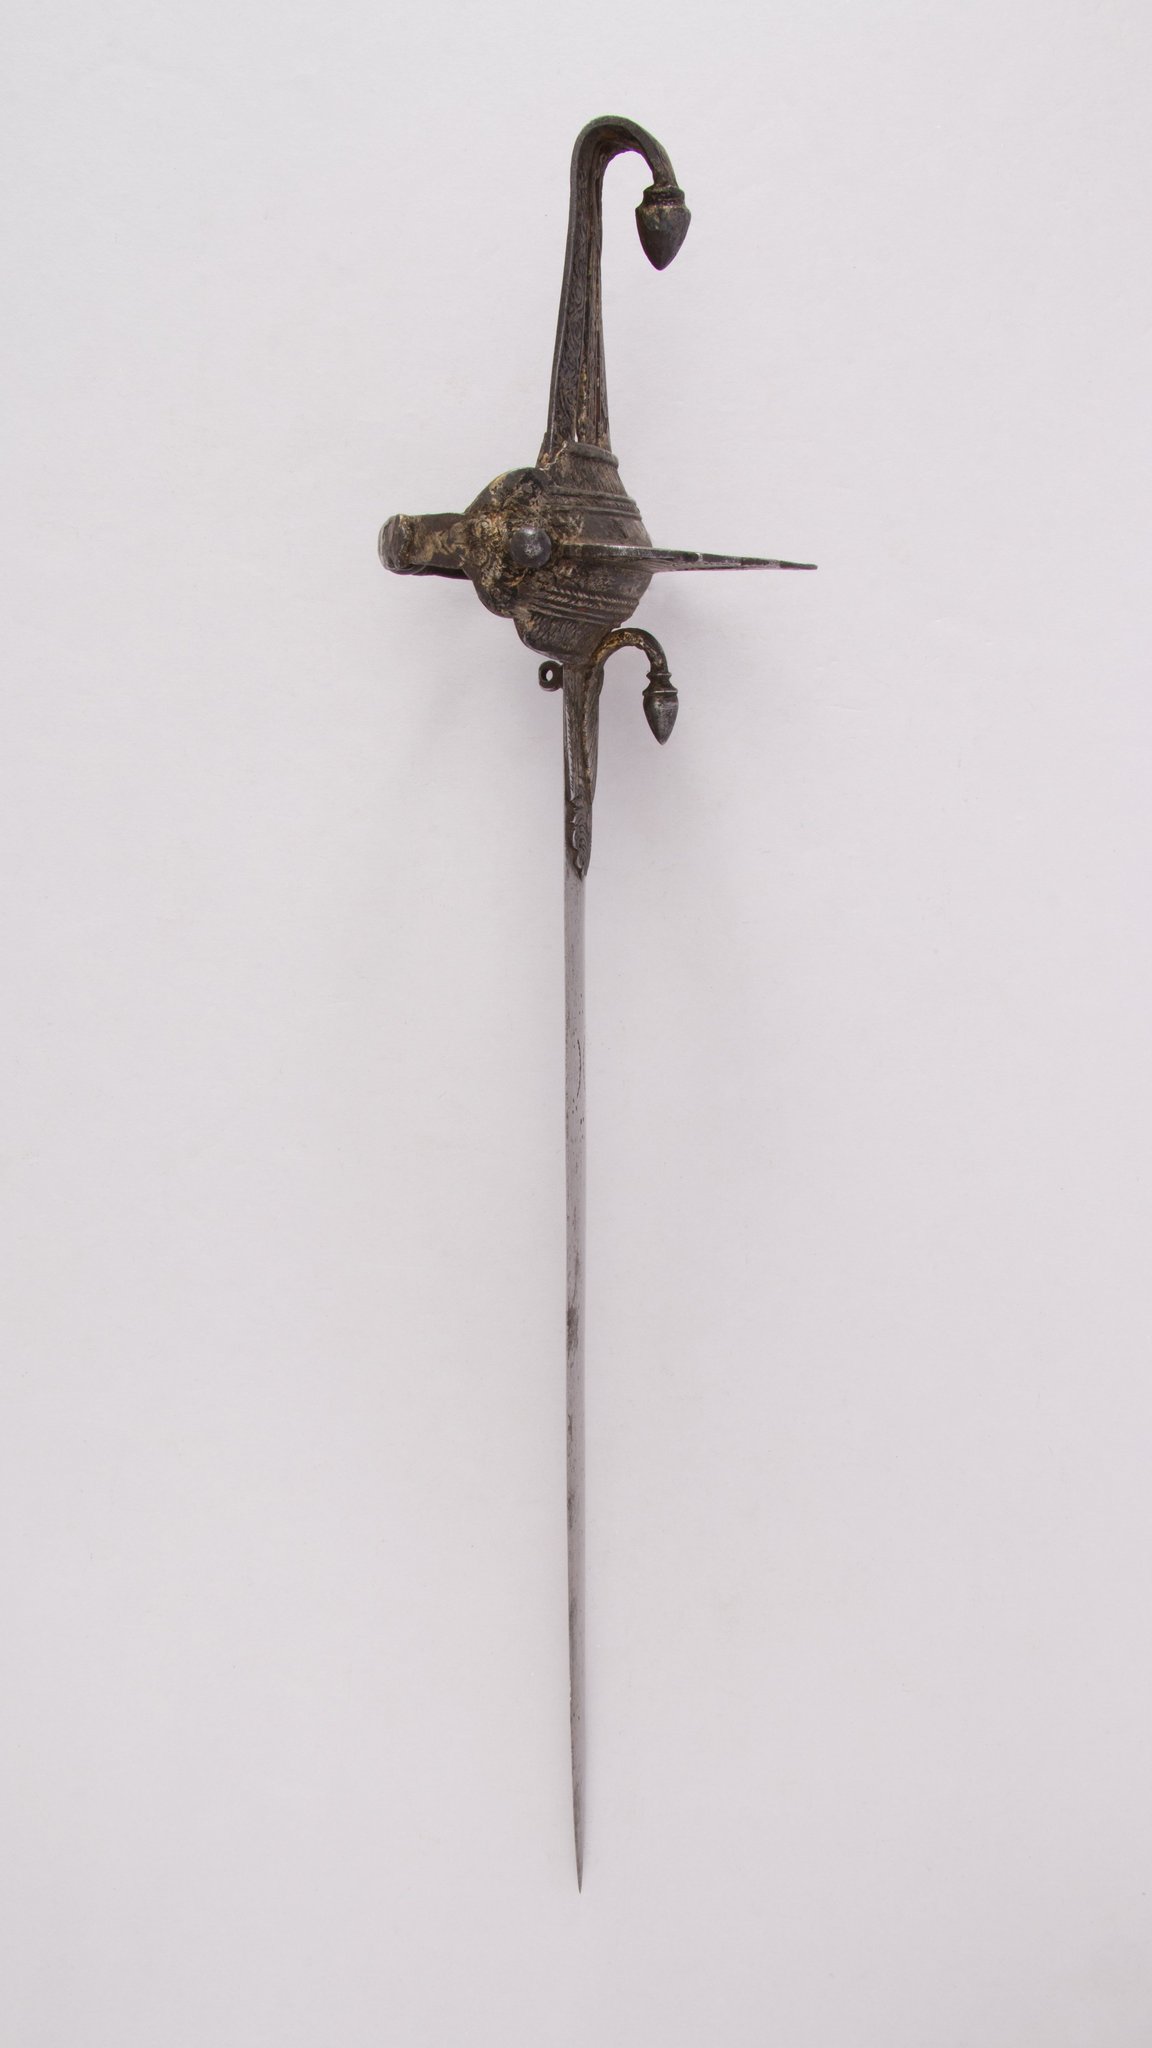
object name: gauntlet dagger pata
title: Gauntlet Dagger (Pata)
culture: european or south indian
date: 1601-1700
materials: iron, silver, steel